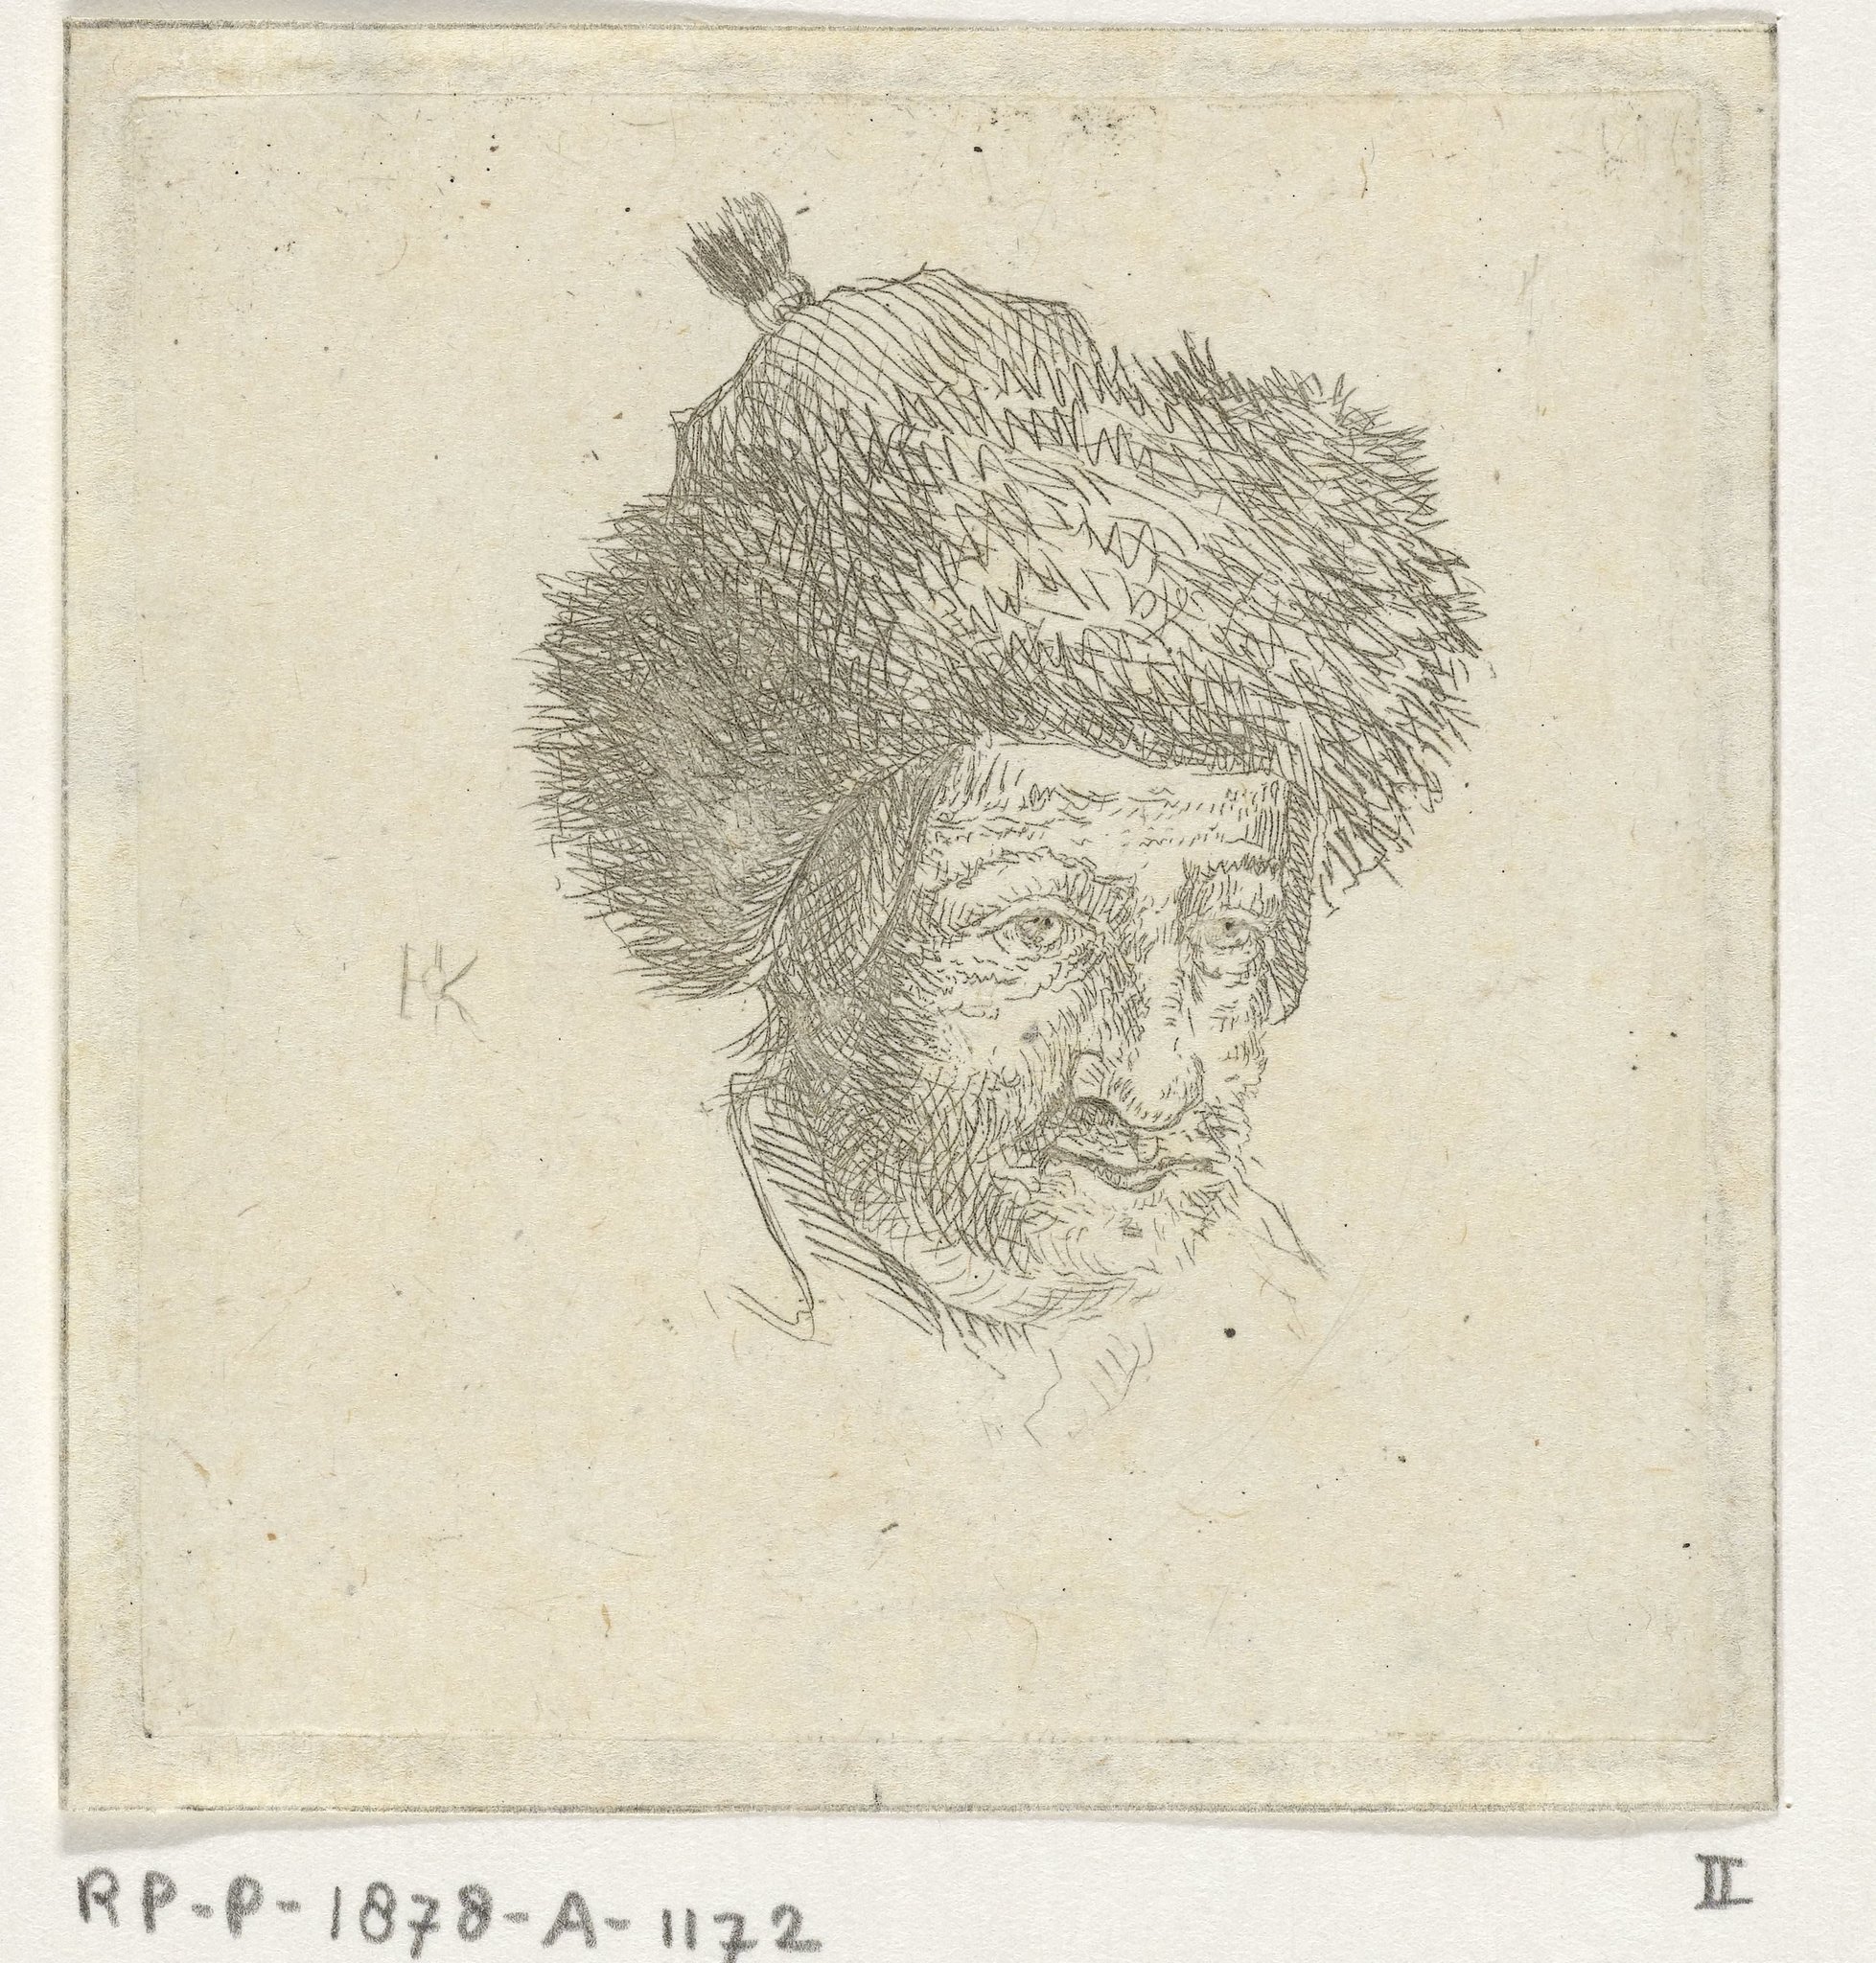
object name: print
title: Mannenkop met bontmuts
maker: hendrik kobell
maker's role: draughtsman, painter, print maker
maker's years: 1751-1779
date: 1761-1779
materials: paper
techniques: etching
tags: old man, head-gear: cap (+ fur used for clothes)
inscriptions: collector's mark: Lugt 2228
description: Oude man met een bontmuts op het hoofd en een baard.